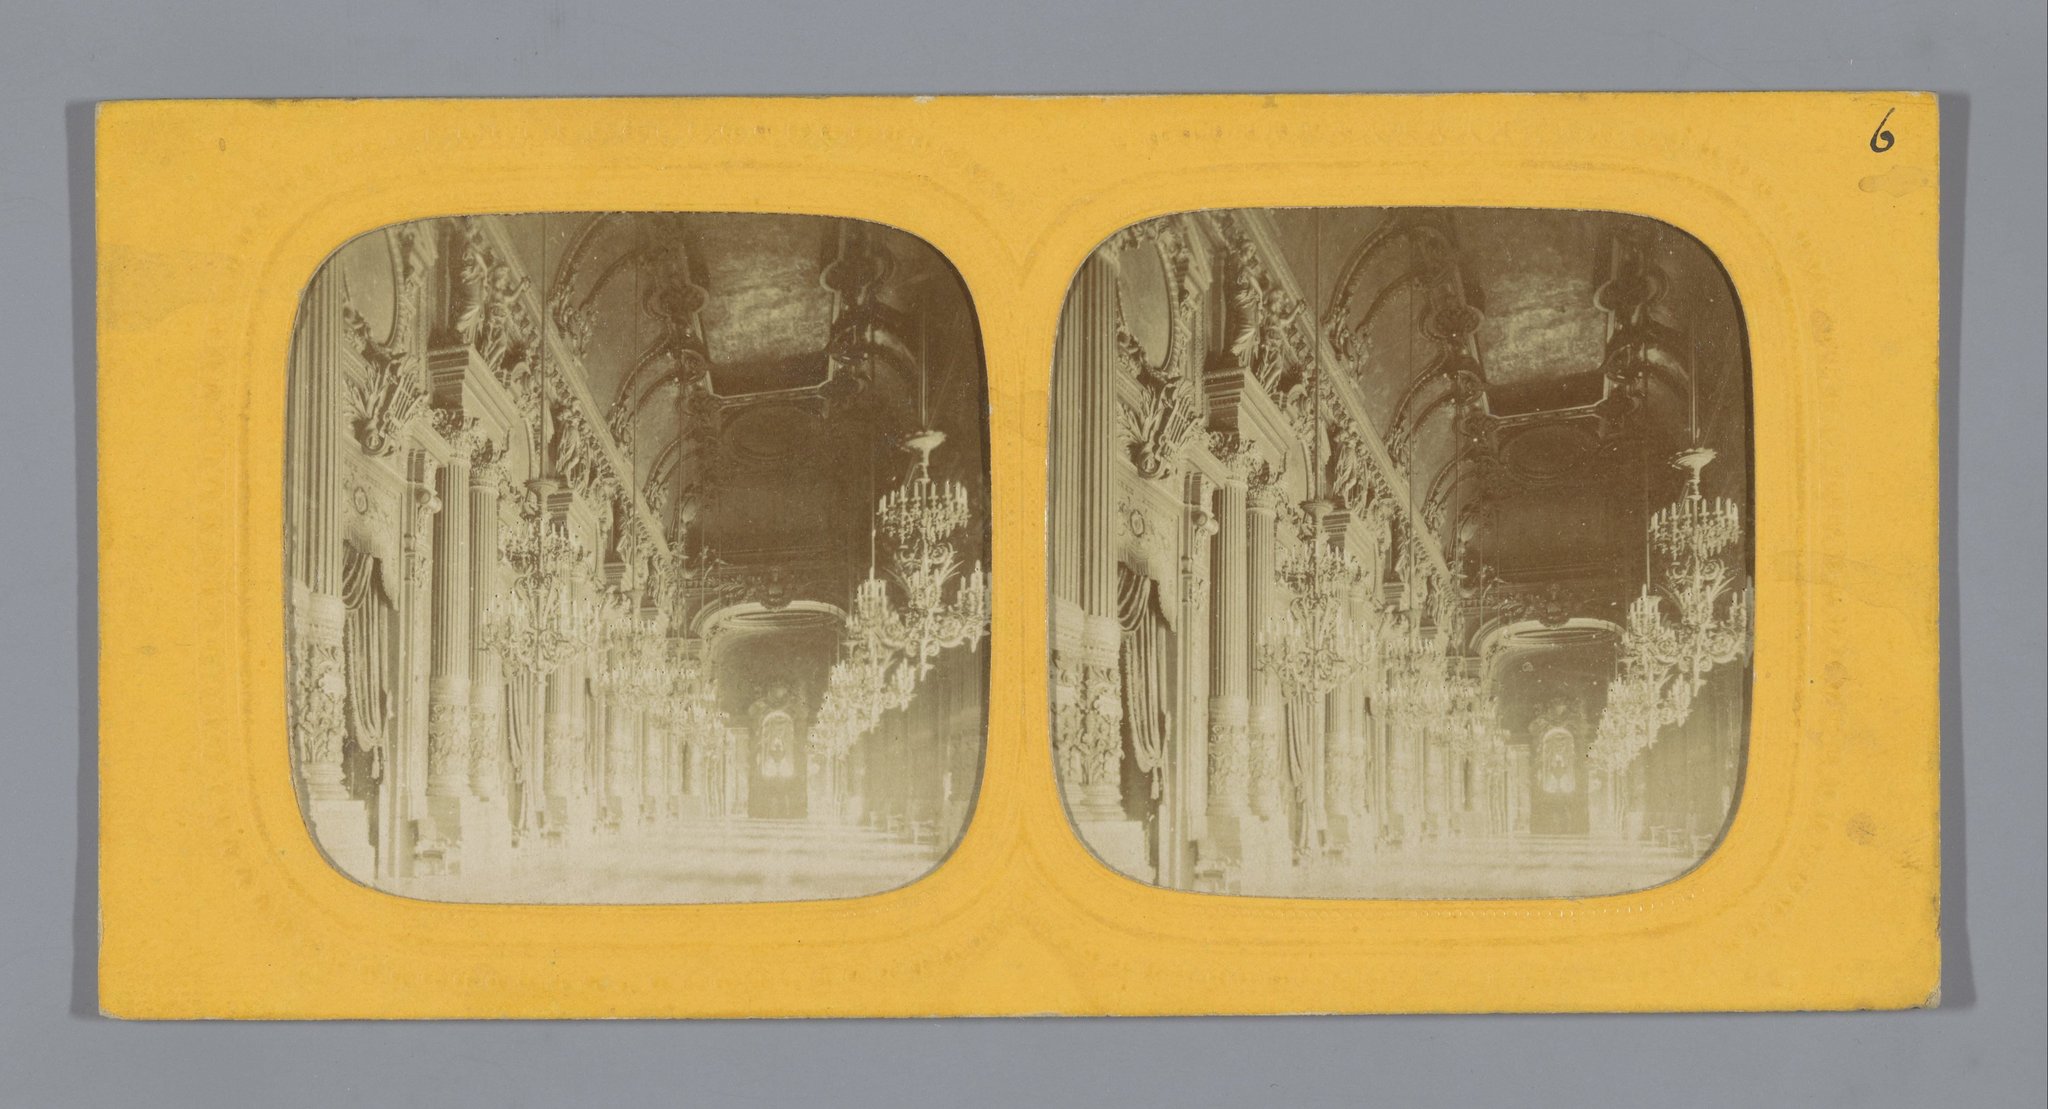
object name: tissue stereograph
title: Foyer de l'Opéra / Koffiekamer van de schouwburg in Parijs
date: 1855-1875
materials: cardboard, paper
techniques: albumen print, hand coloring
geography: paris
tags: foyer ~ theatre, etc.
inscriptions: number: ‘6’